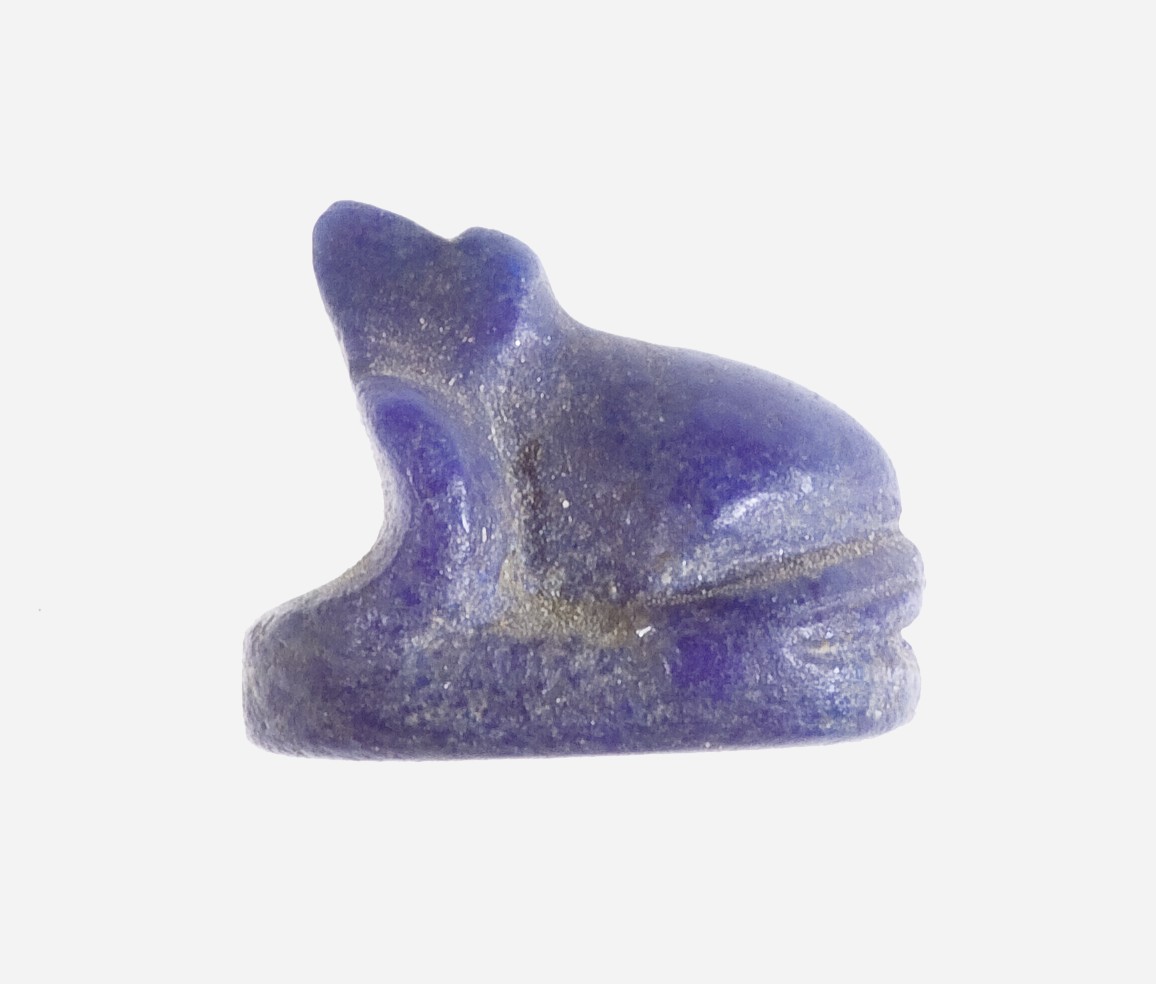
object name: seal, frog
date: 1295-1070 BCE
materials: lapis lazuli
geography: egypt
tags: frogs